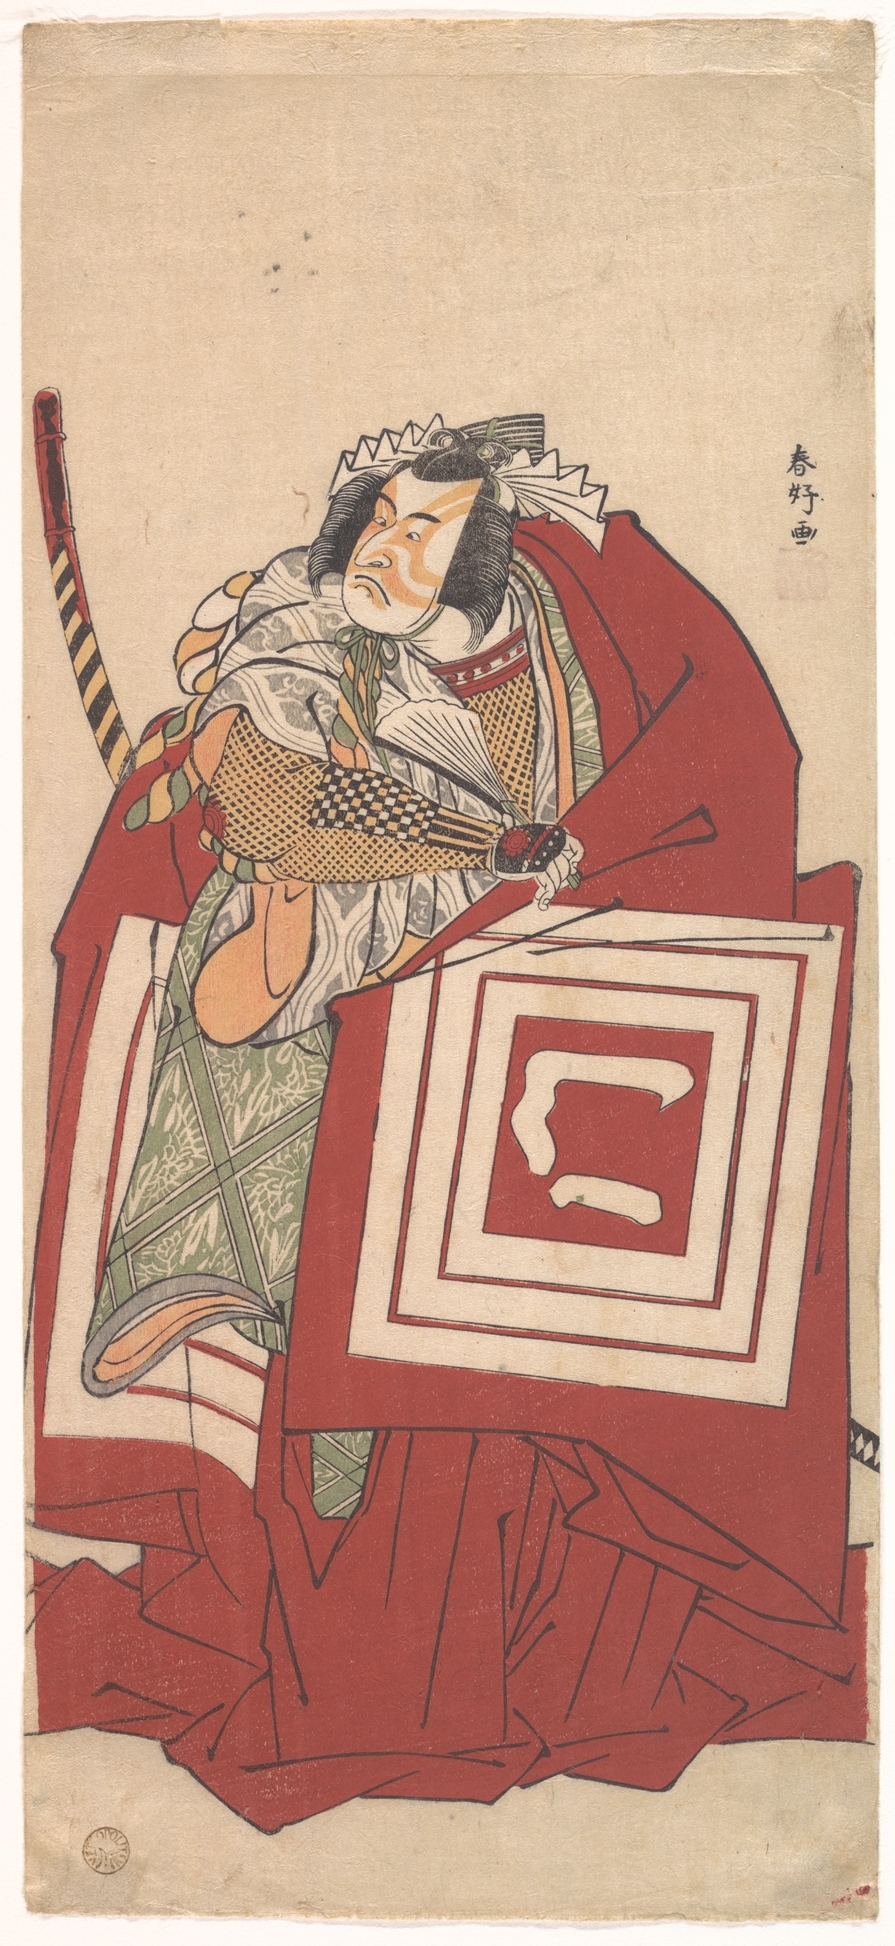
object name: print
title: Kabuki Actor Ichikawa Monnosuke II as Shinozuka in a Shibaraku (Stop Right There!) Scene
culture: japanese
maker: katsukawa shunkō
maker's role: artist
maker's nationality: japanese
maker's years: 1743-1812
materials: ink, paper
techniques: woodblock print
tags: swords,men,actors